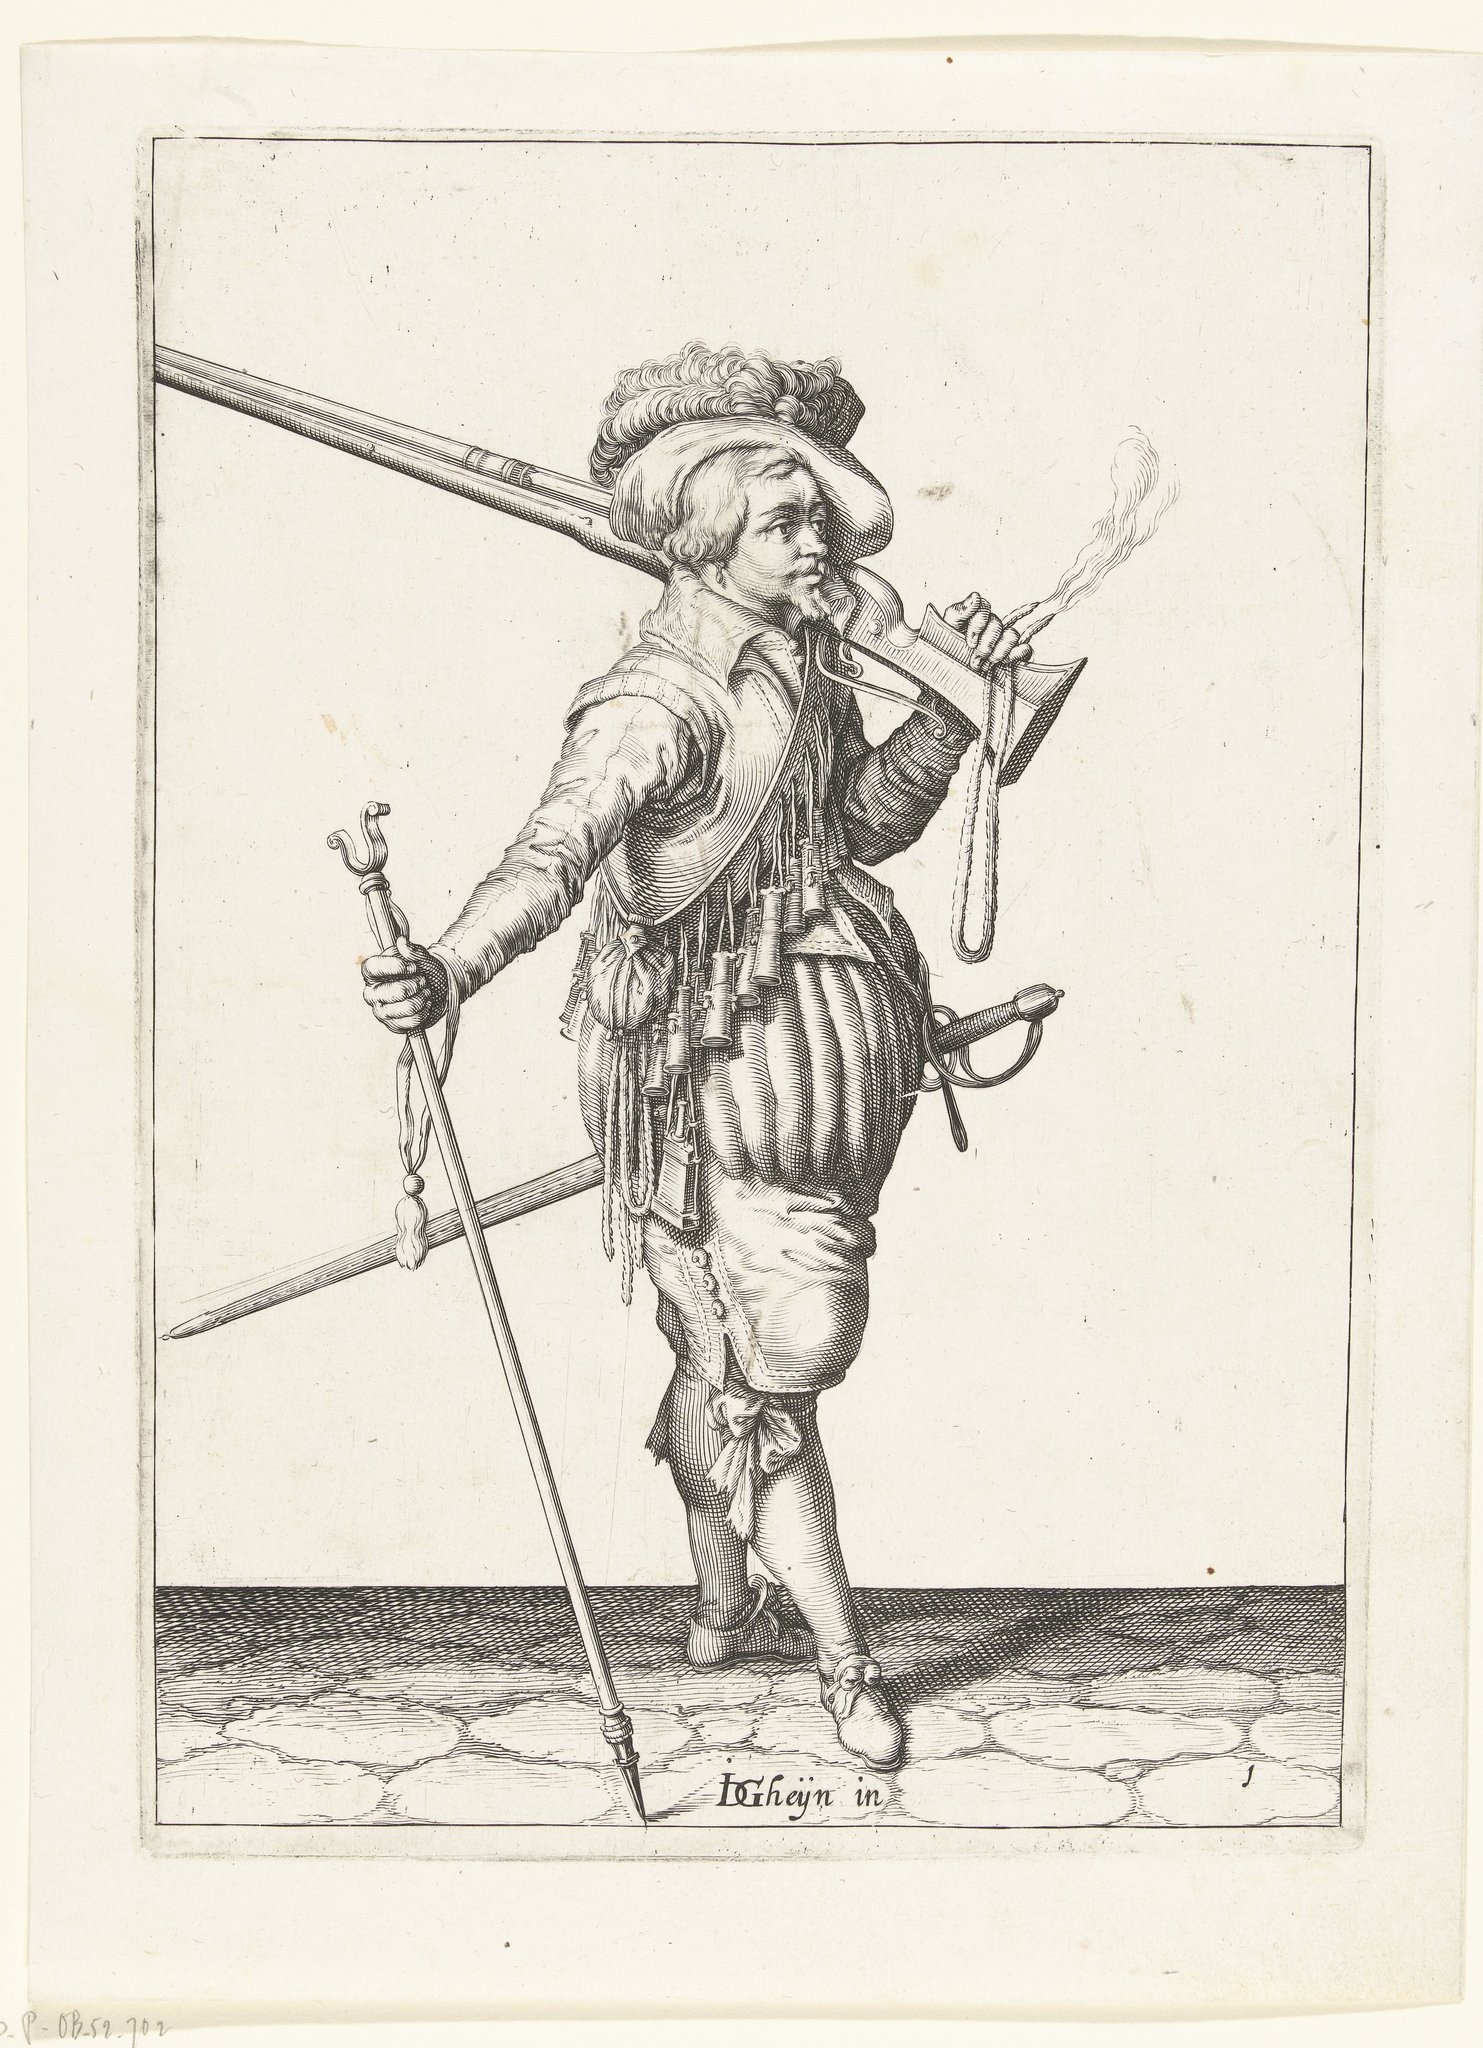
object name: print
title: Soldaat die zijn musket op zijn linkerschouder draagt en zijn furket in zijn rechterhand vasthoudt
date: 1597-1607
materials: paper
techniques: engraving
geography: netherlands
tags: manoeuvre ~ military training, firearms: rifle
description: Een soldaat, ten voeten uit, naar rechts, met een musket (een bepaald type vuurwapen) steunend op zijn linkerschouder. In zijn linkerhand behalve de kolf van het musket ook een brandende lont. In zijn rechterhand een furket (musketvork). Deze prent is onderdeel van de reeks van 43 genummerde prenten van musketiers uit de Wapenhandelinghe.